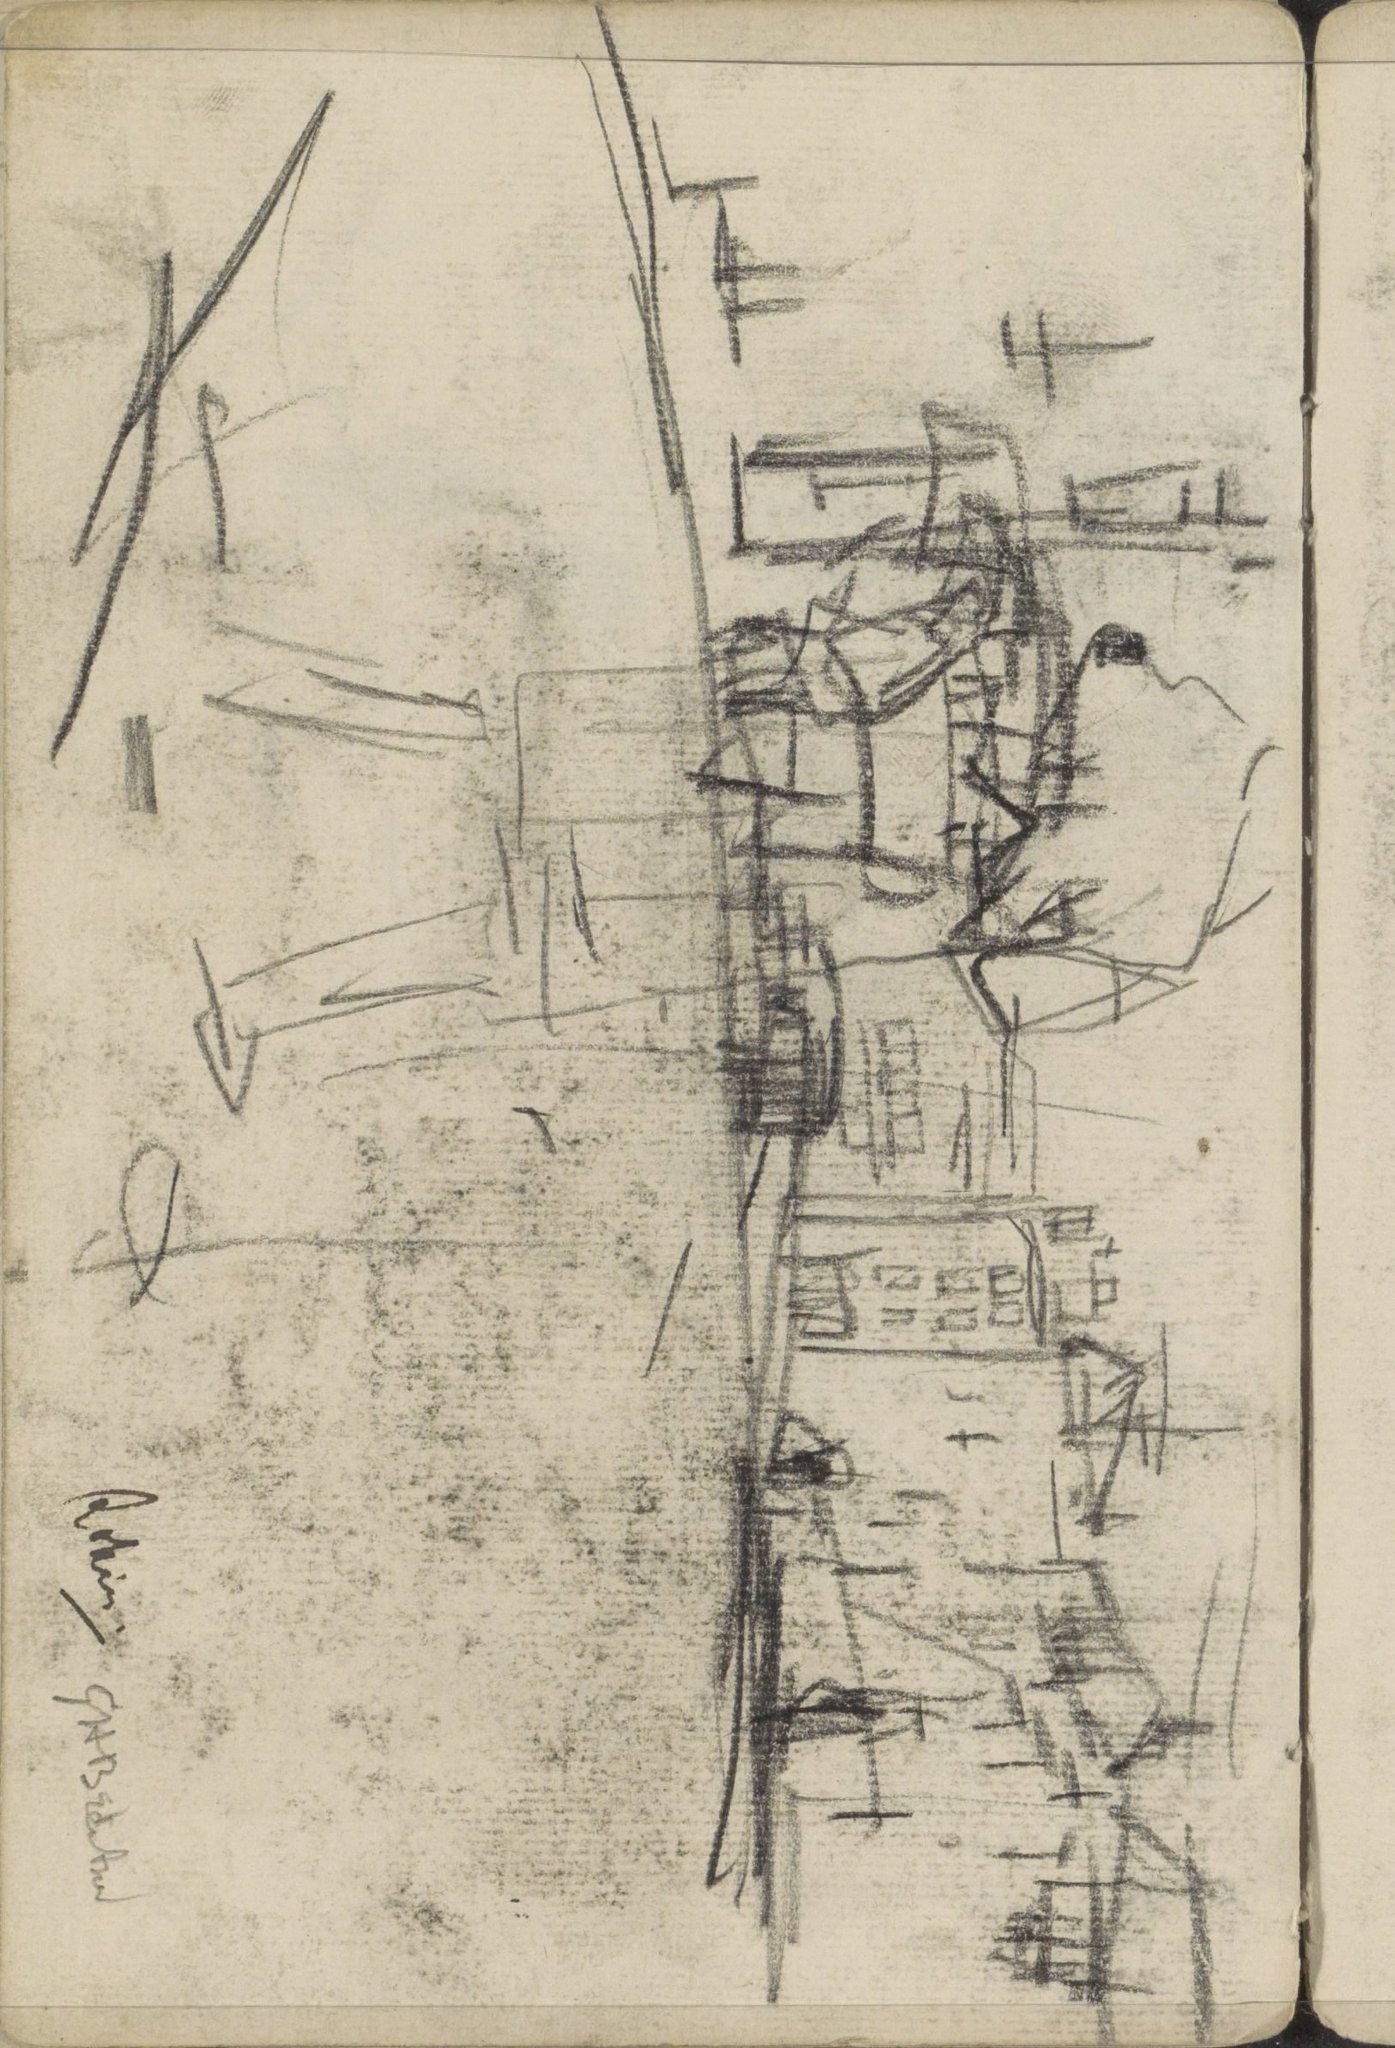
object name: sketchbook leaf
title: Gezicht op het Rokin te Amsterdam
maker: george hendrik breitner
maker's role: draughtsman, painter, print maker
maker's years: 1857-1923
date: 1886-1923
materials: chalk, paper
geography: amsterdam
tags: civic architecture; edifices; dwellings, canals, waters (in city) (+ city(-scape) with figures, staffage)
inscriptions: annotation: ‘Rokin’, signature: ‘G.H. Breitner’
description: Pagina 51 uit een schetsboek met 19 bladen en 9 losse tekeningen.